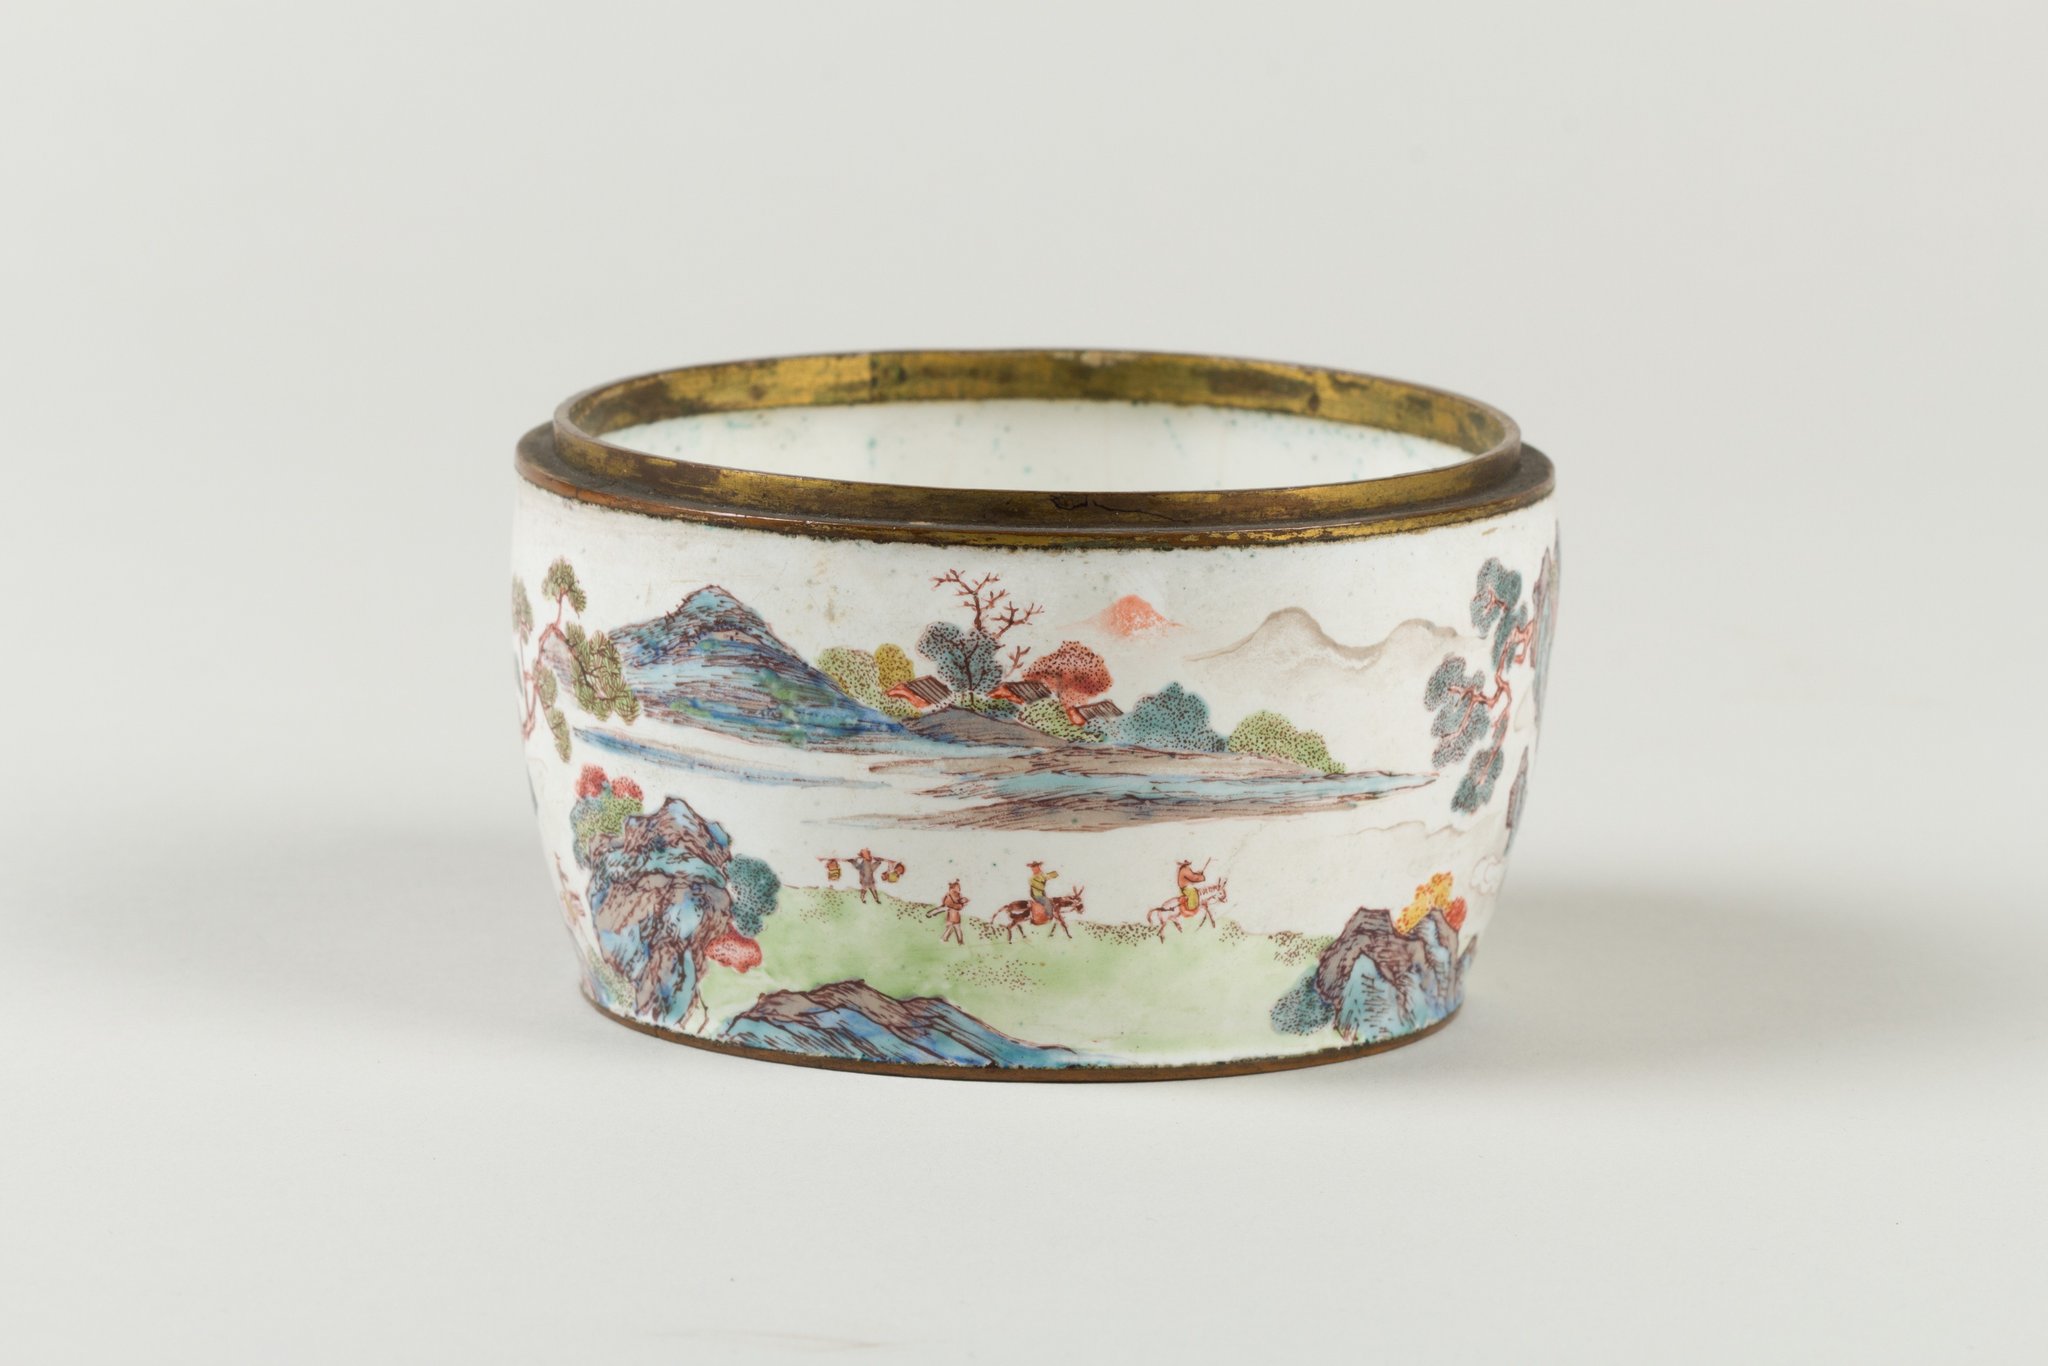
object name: box base one of a pair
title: Box base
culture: chinese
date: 1736-1795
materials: enamel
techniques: painting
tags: mountains,trees